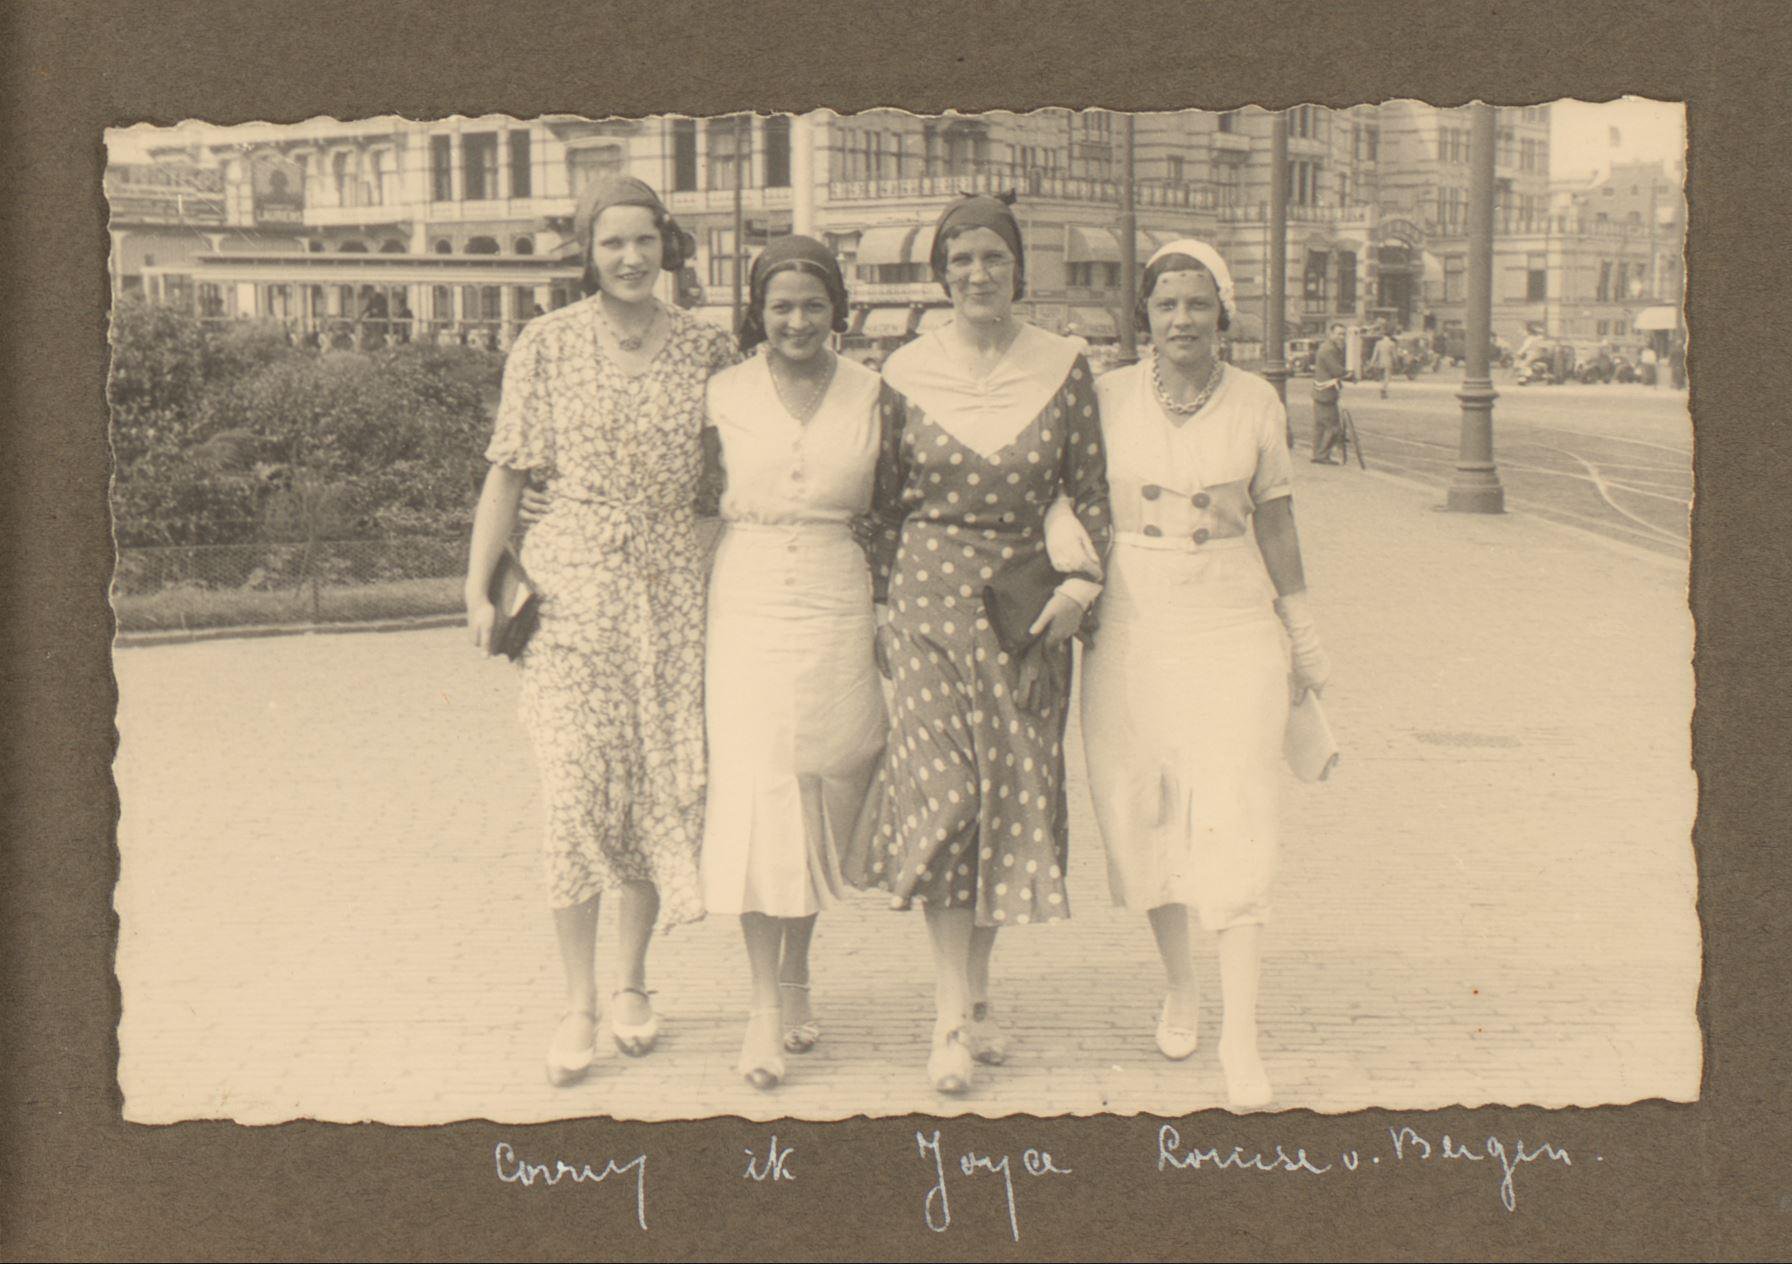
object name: photograph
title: Groepsportret van vier vrouwen, lopend in Scheveningen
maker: Anonymous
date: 1907-1932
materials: paper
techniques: gelatin silver print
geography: scheveningen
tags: palembang (city), the hague, wilhelmina van zijll de jong, historical persons - bb - woman, strolling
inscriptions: inscription: ‘Corry ik Joyce Louise v. Bergen’